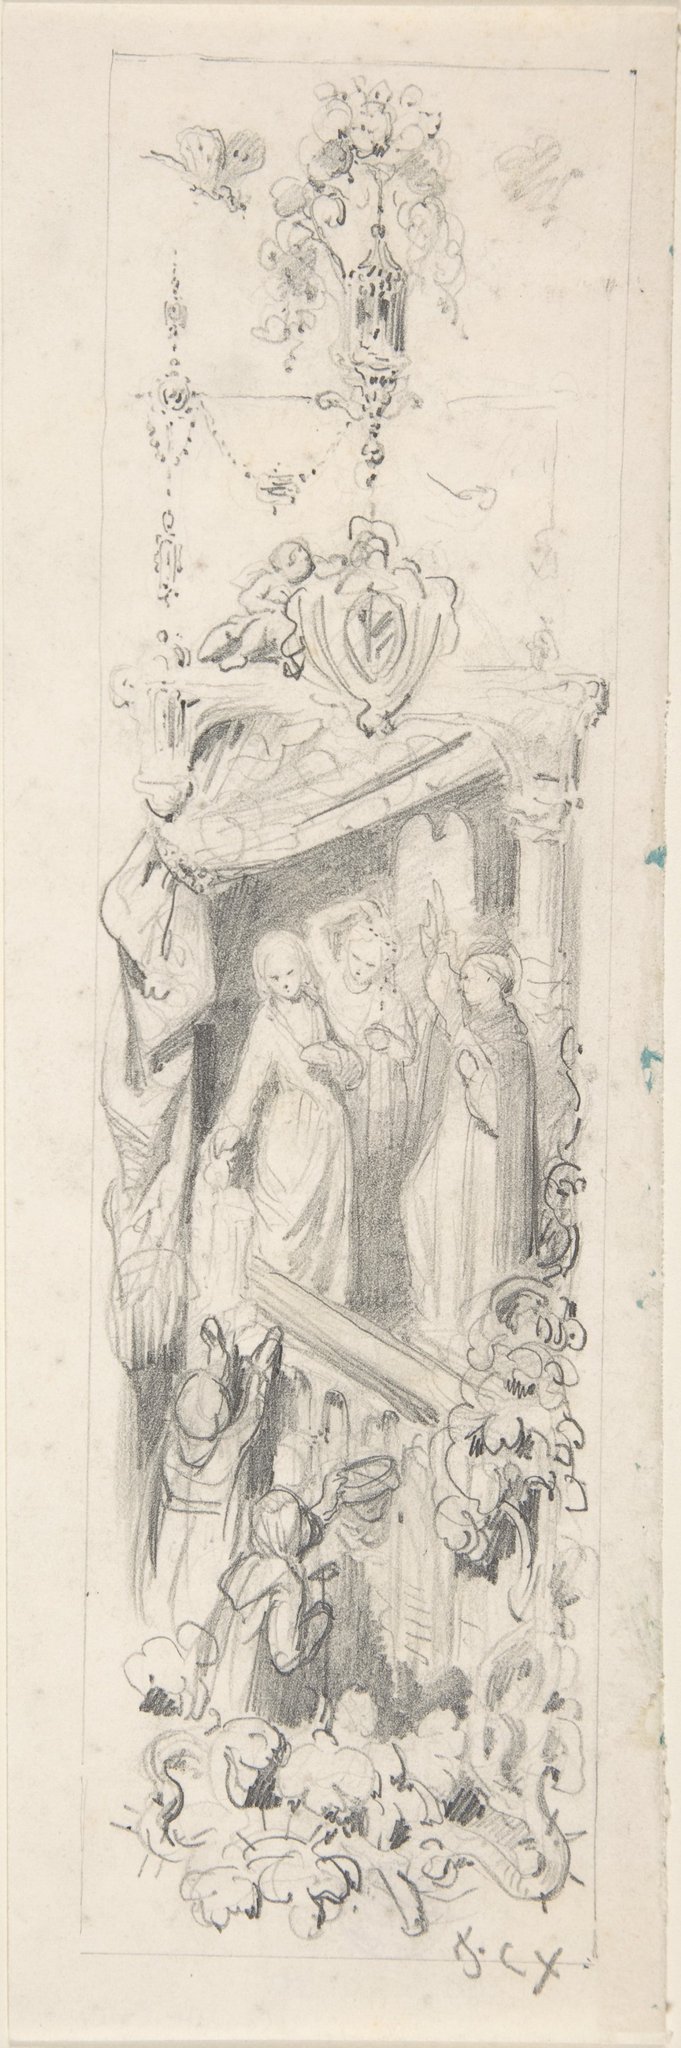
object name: drawing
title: Decorative study of a play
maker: françois-claudius compte-calix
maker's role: artist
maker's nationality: french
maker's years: 1813-1880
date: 1830-1880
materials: graphite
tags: women,butterflies,flowers